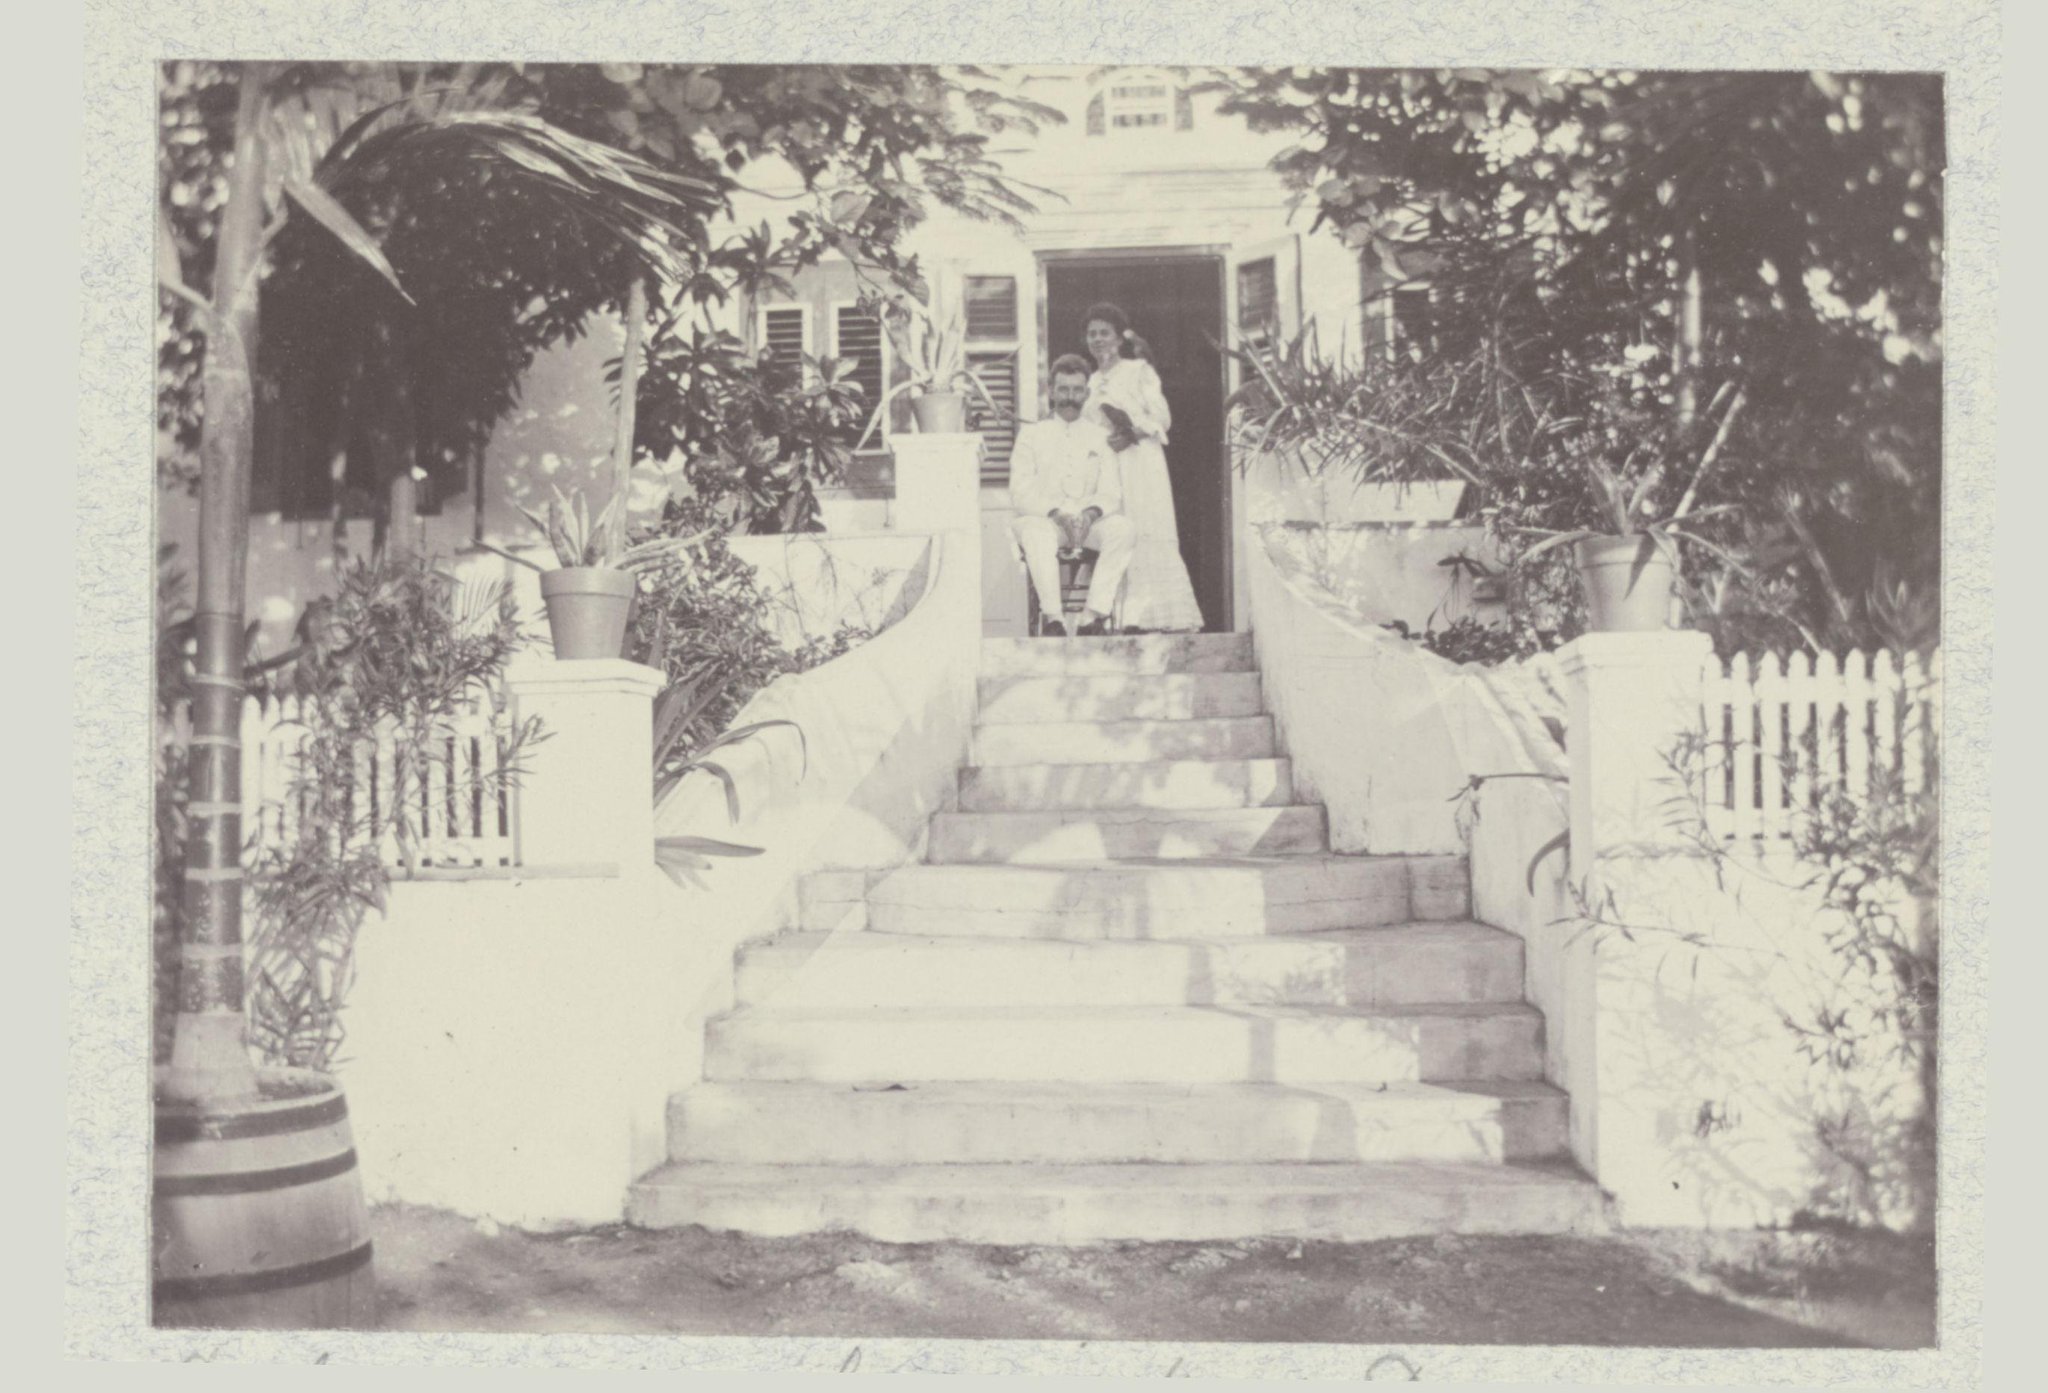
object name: photograph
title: De heer en mevrouw Land op Curaçao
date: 1902-1911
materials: photographic support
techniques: photography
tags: curaçao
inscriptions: inscription: ‘De Heer en Mevr. Land op Klein Davelaar / Curaçao. Febr. 1911’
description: De heer en mevrouw Land, in de deur van hun huis op Klein Davelaar op Curaçao, februari 1911. Onderdeel van het fotoalbum van de familie Boom-Gonggrijp in Suriname en Curaçao.